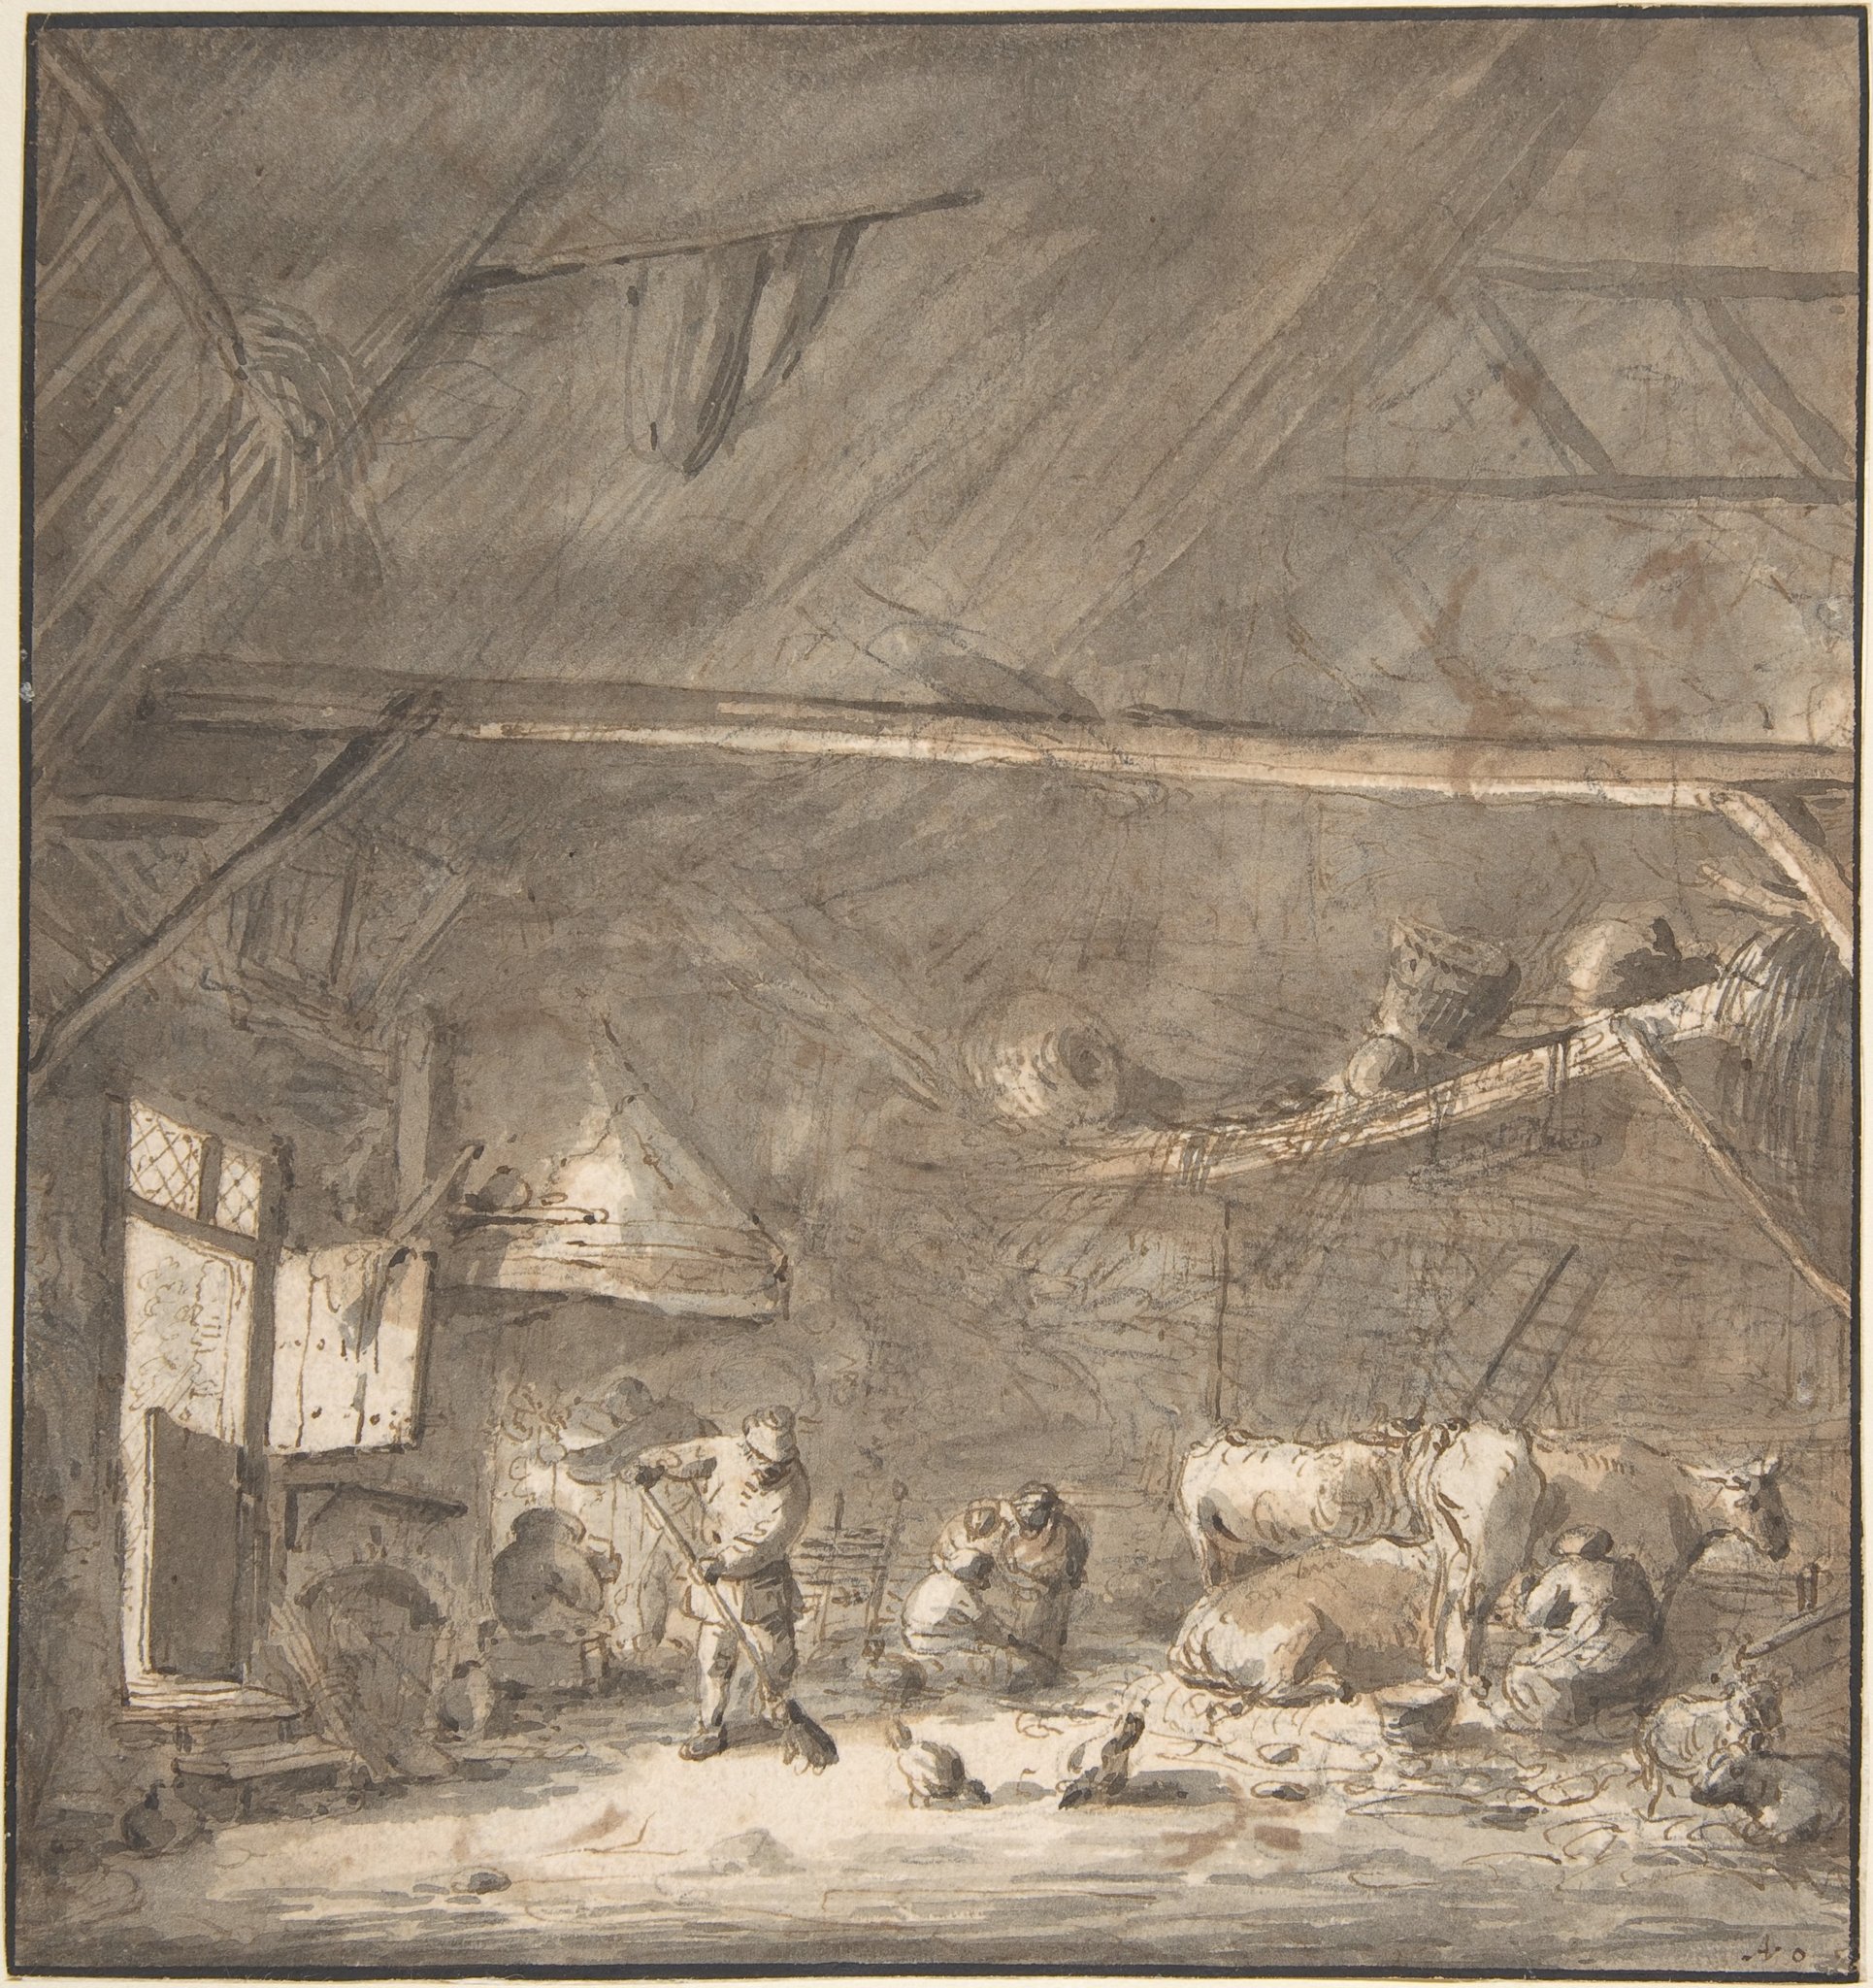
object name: drawing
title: Barn Interior with Peasants and Cows (recto); Six Studies of Peasants (verso)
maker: isaac van ostade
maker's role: artist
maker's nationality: dutch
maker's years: 1621-1649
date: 1601-1700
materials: graphite, ink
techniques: brush, pen, wash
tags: men,cows,working